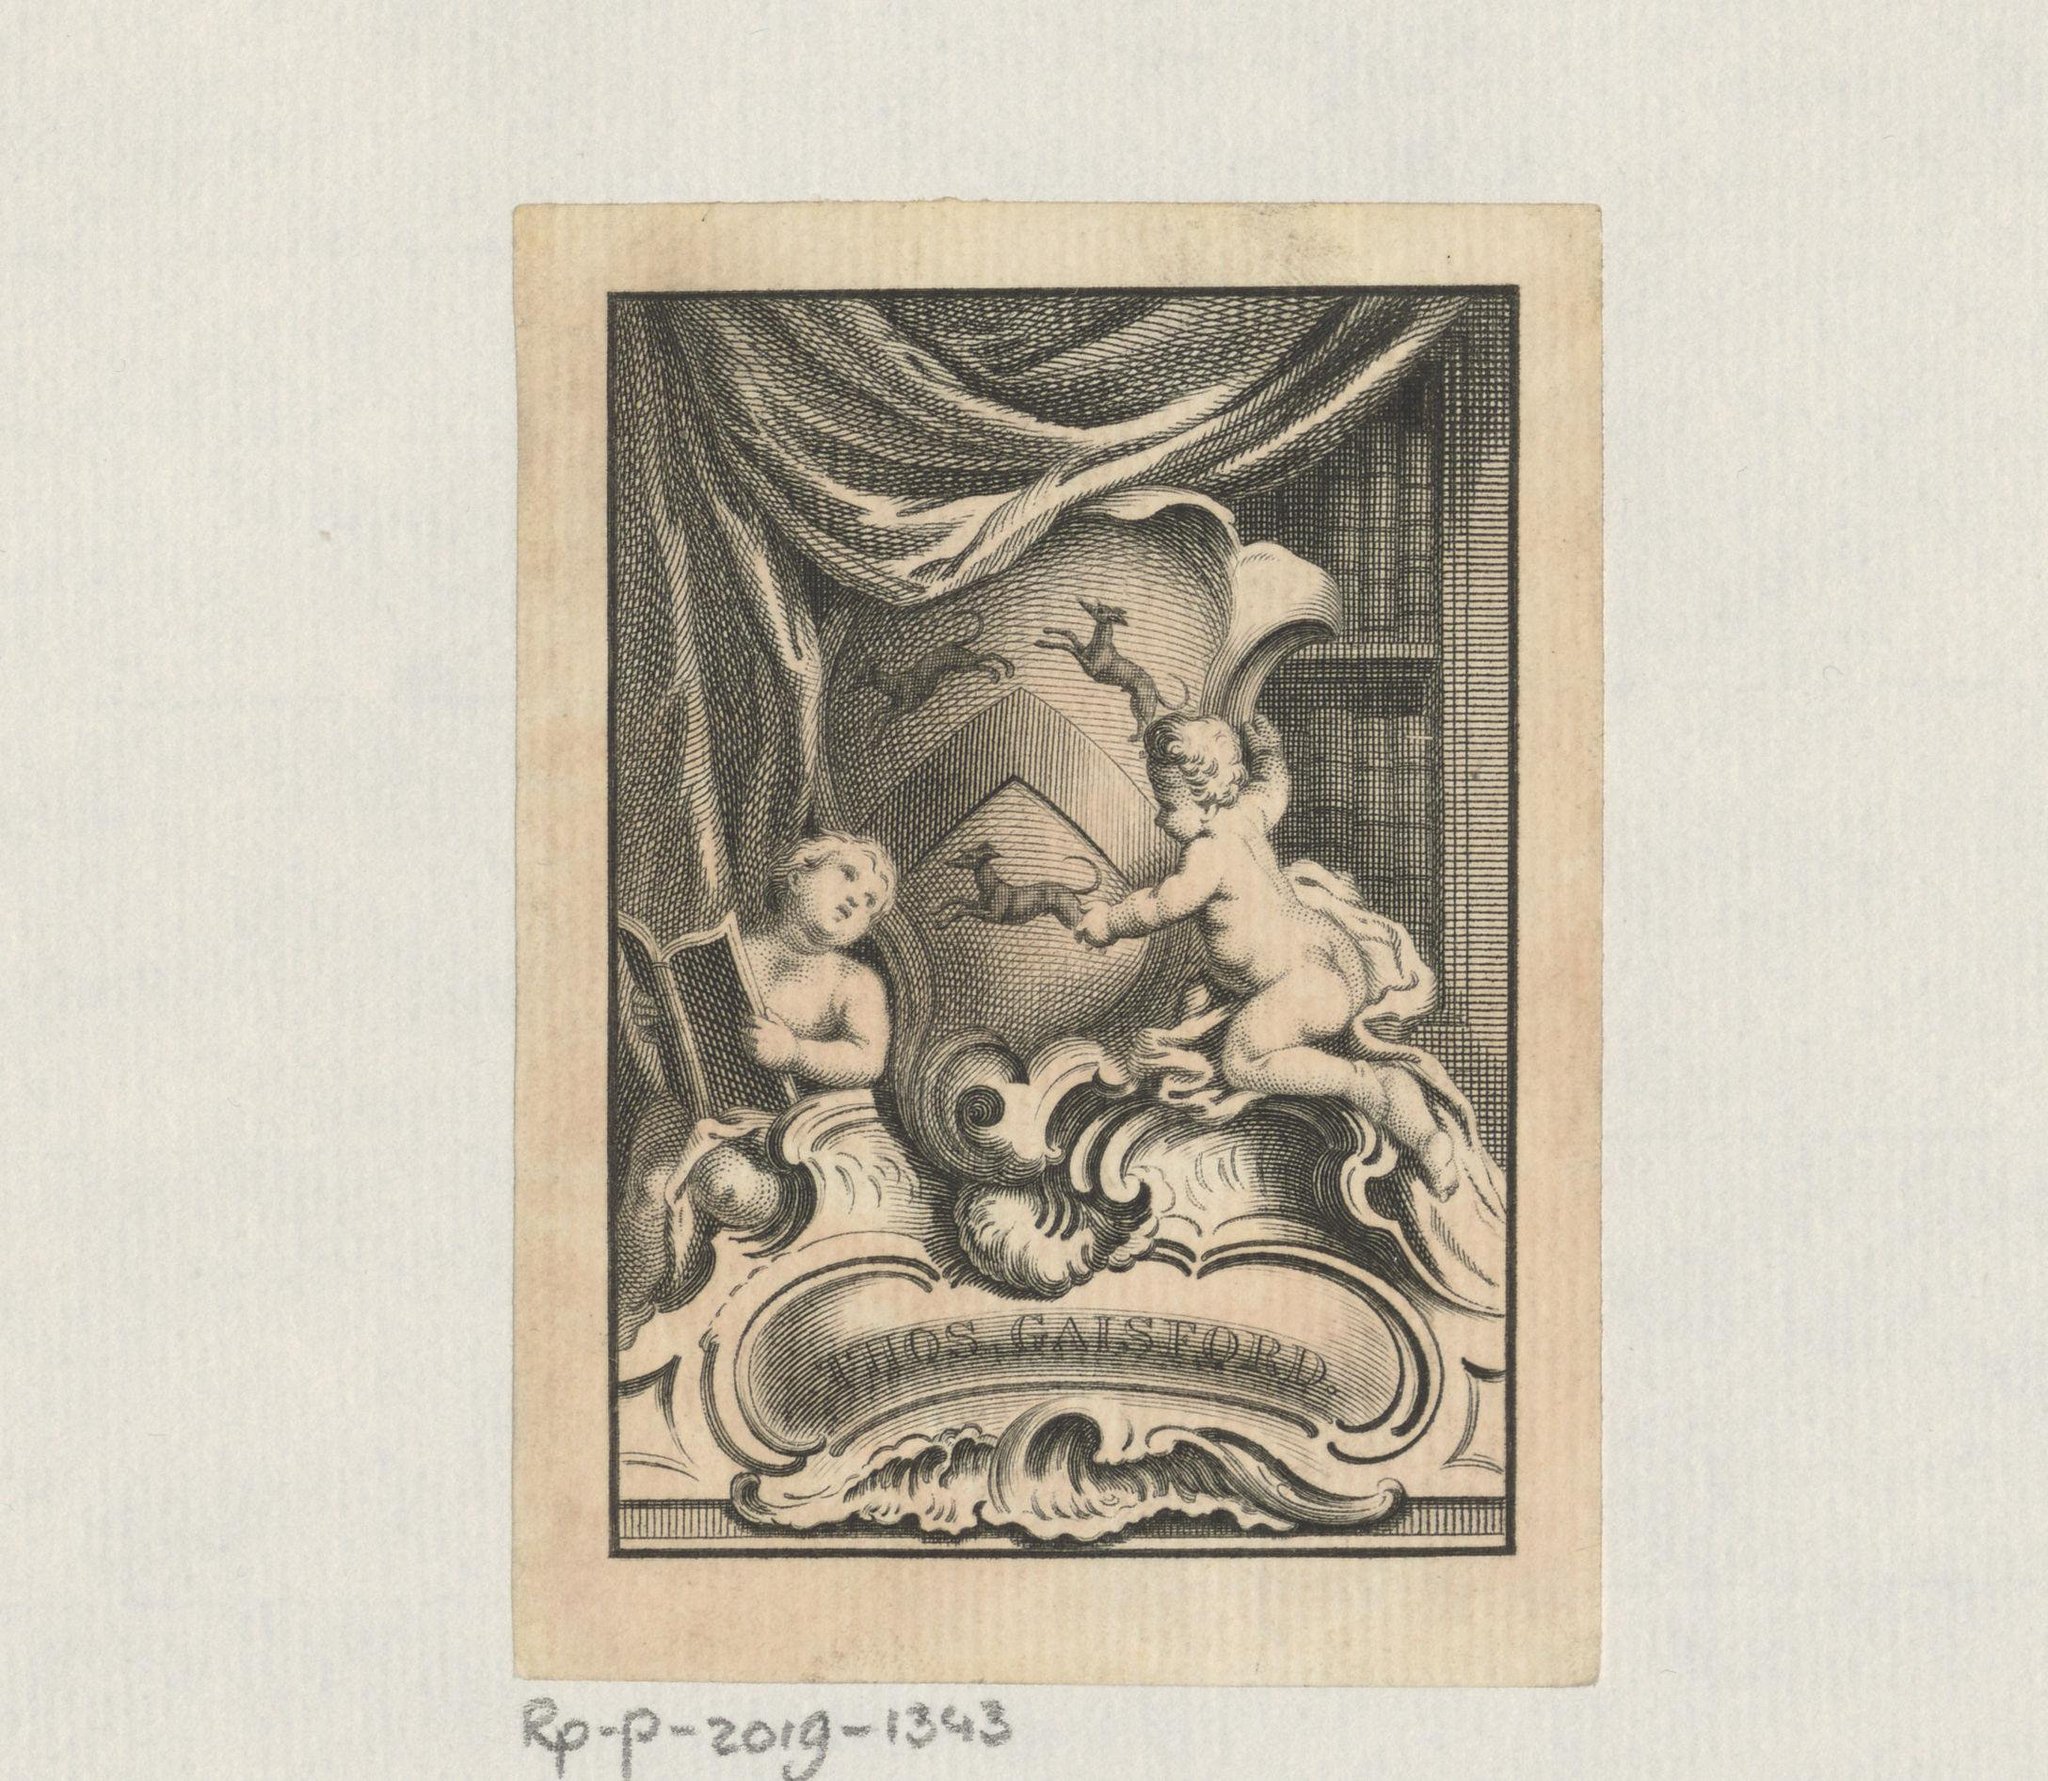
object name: bookplate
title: Ex libris van Thos. Galsford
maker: Anonymous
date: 1700-1799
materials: paper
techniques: engraving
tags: armorial bearing, heraldry